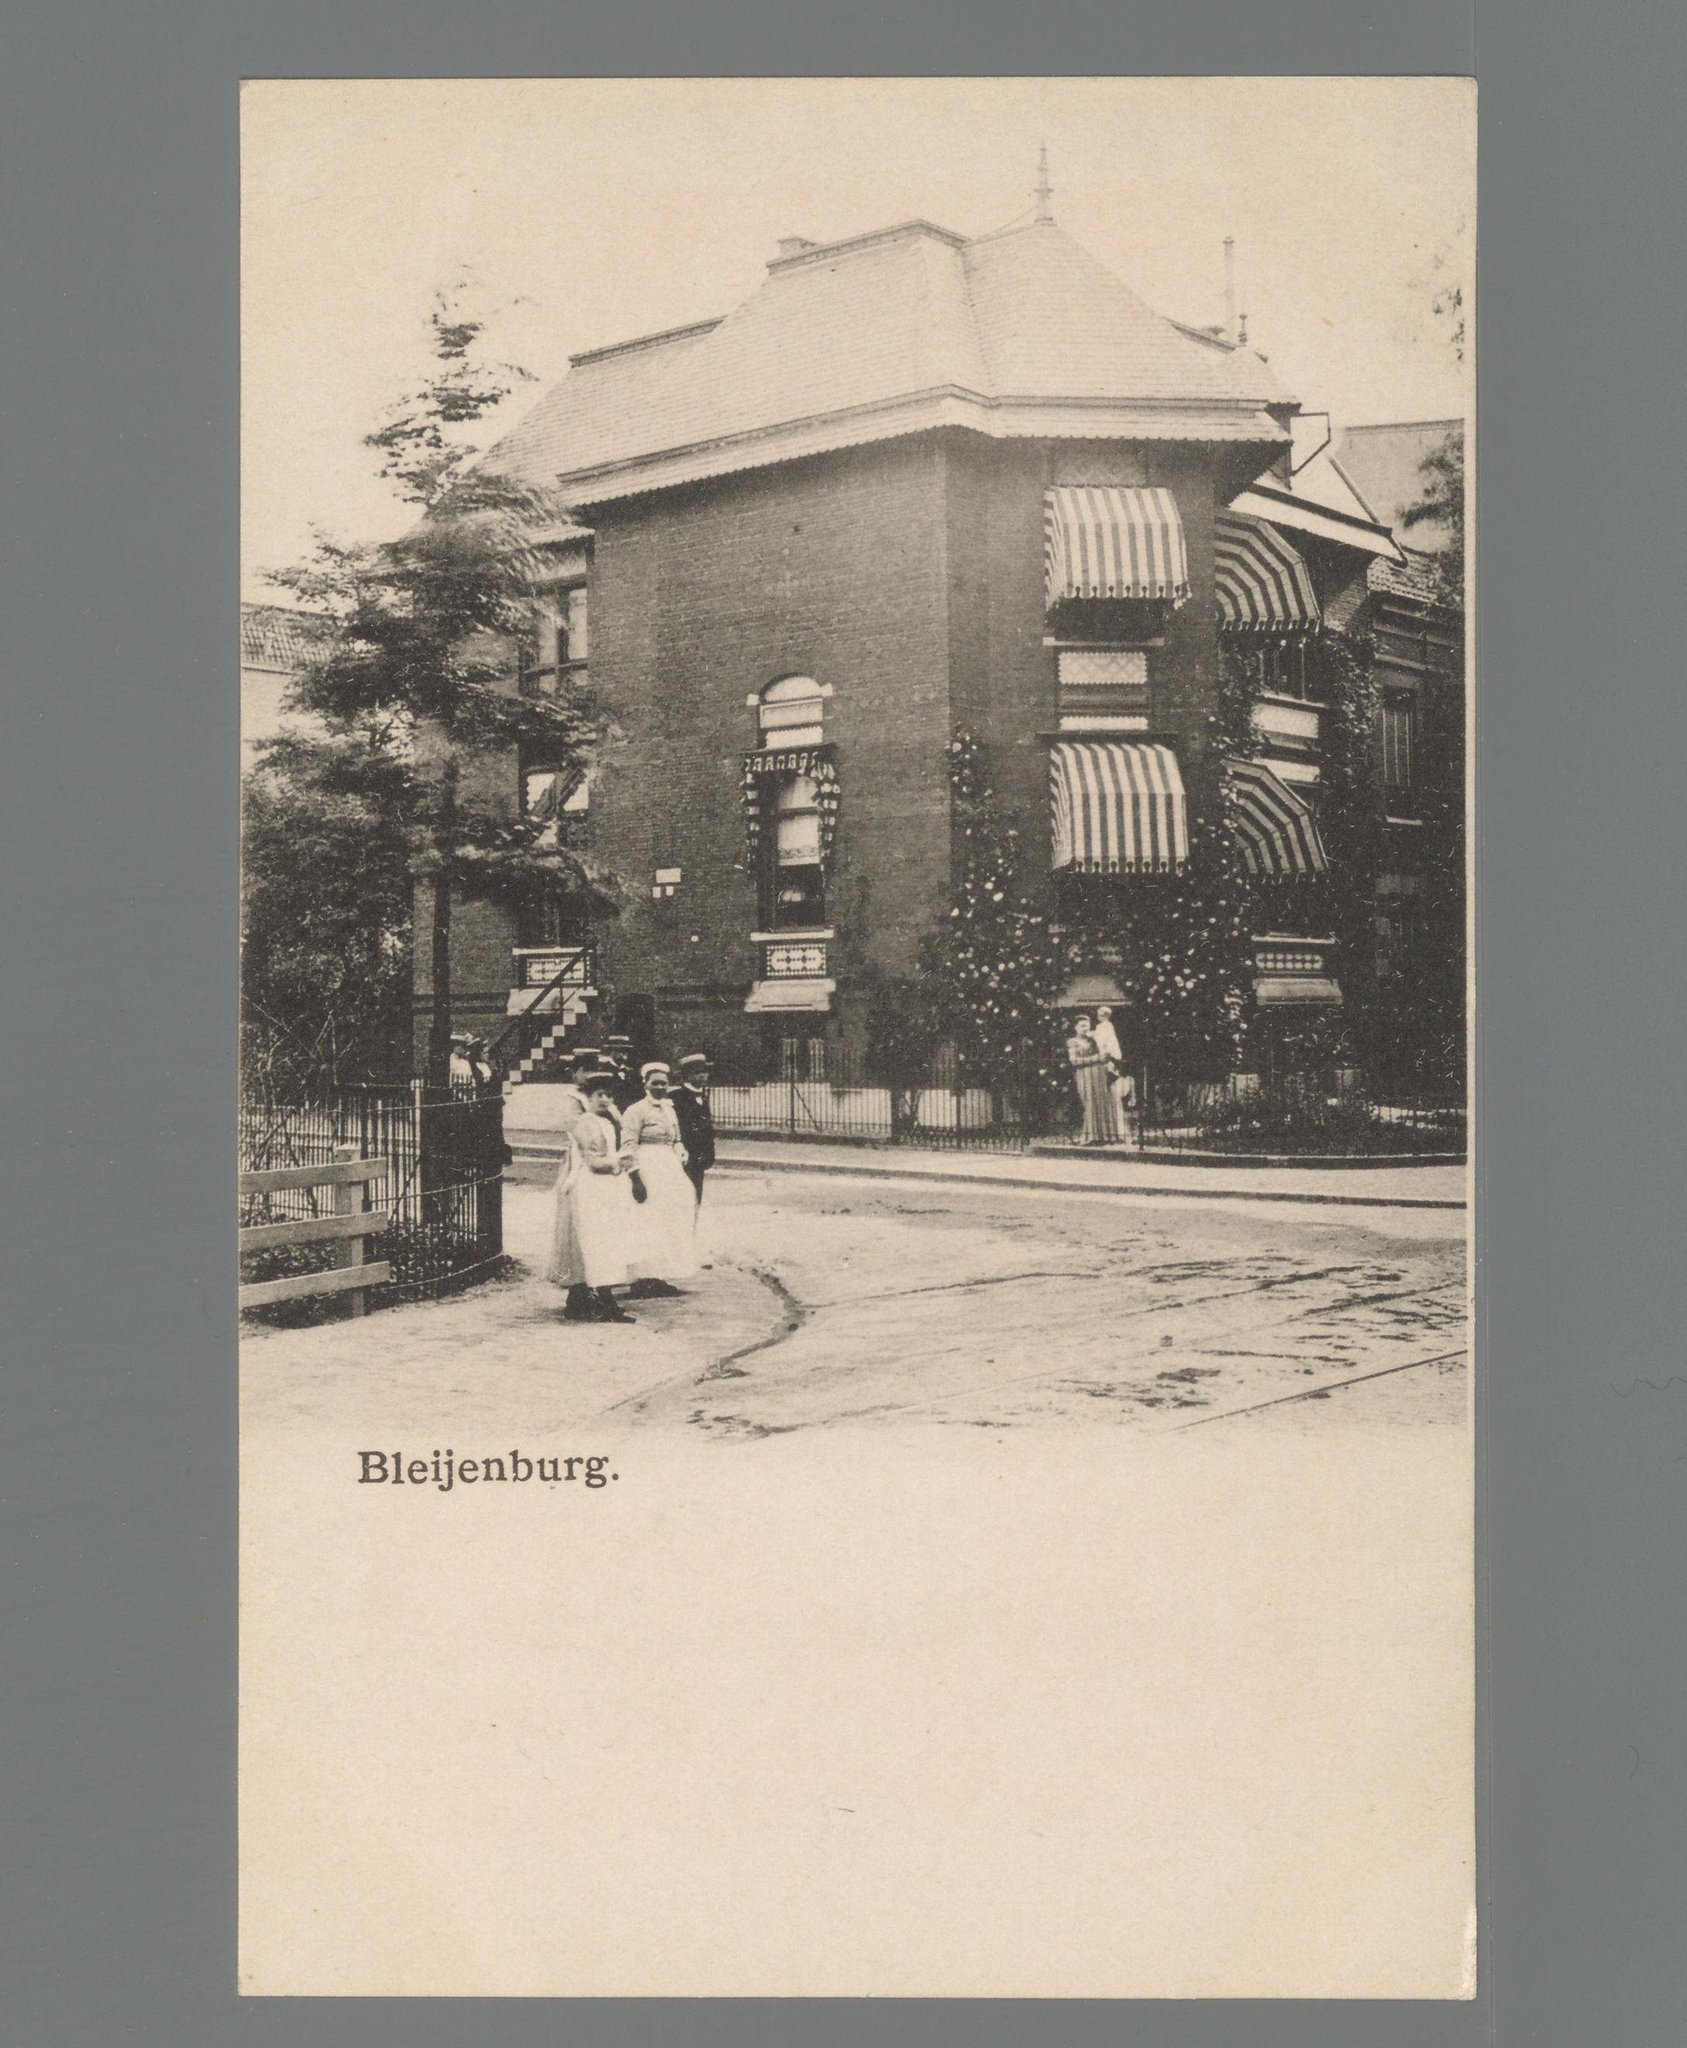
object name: ansichtkaart, prentbriefkaart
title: Utrecht. Standbeeld Graaf Jan van Nassau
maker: Anonymous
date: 1914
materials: cardboard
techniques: rotogravure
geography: utrecht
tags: church (exterior), monument, statue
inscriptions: date